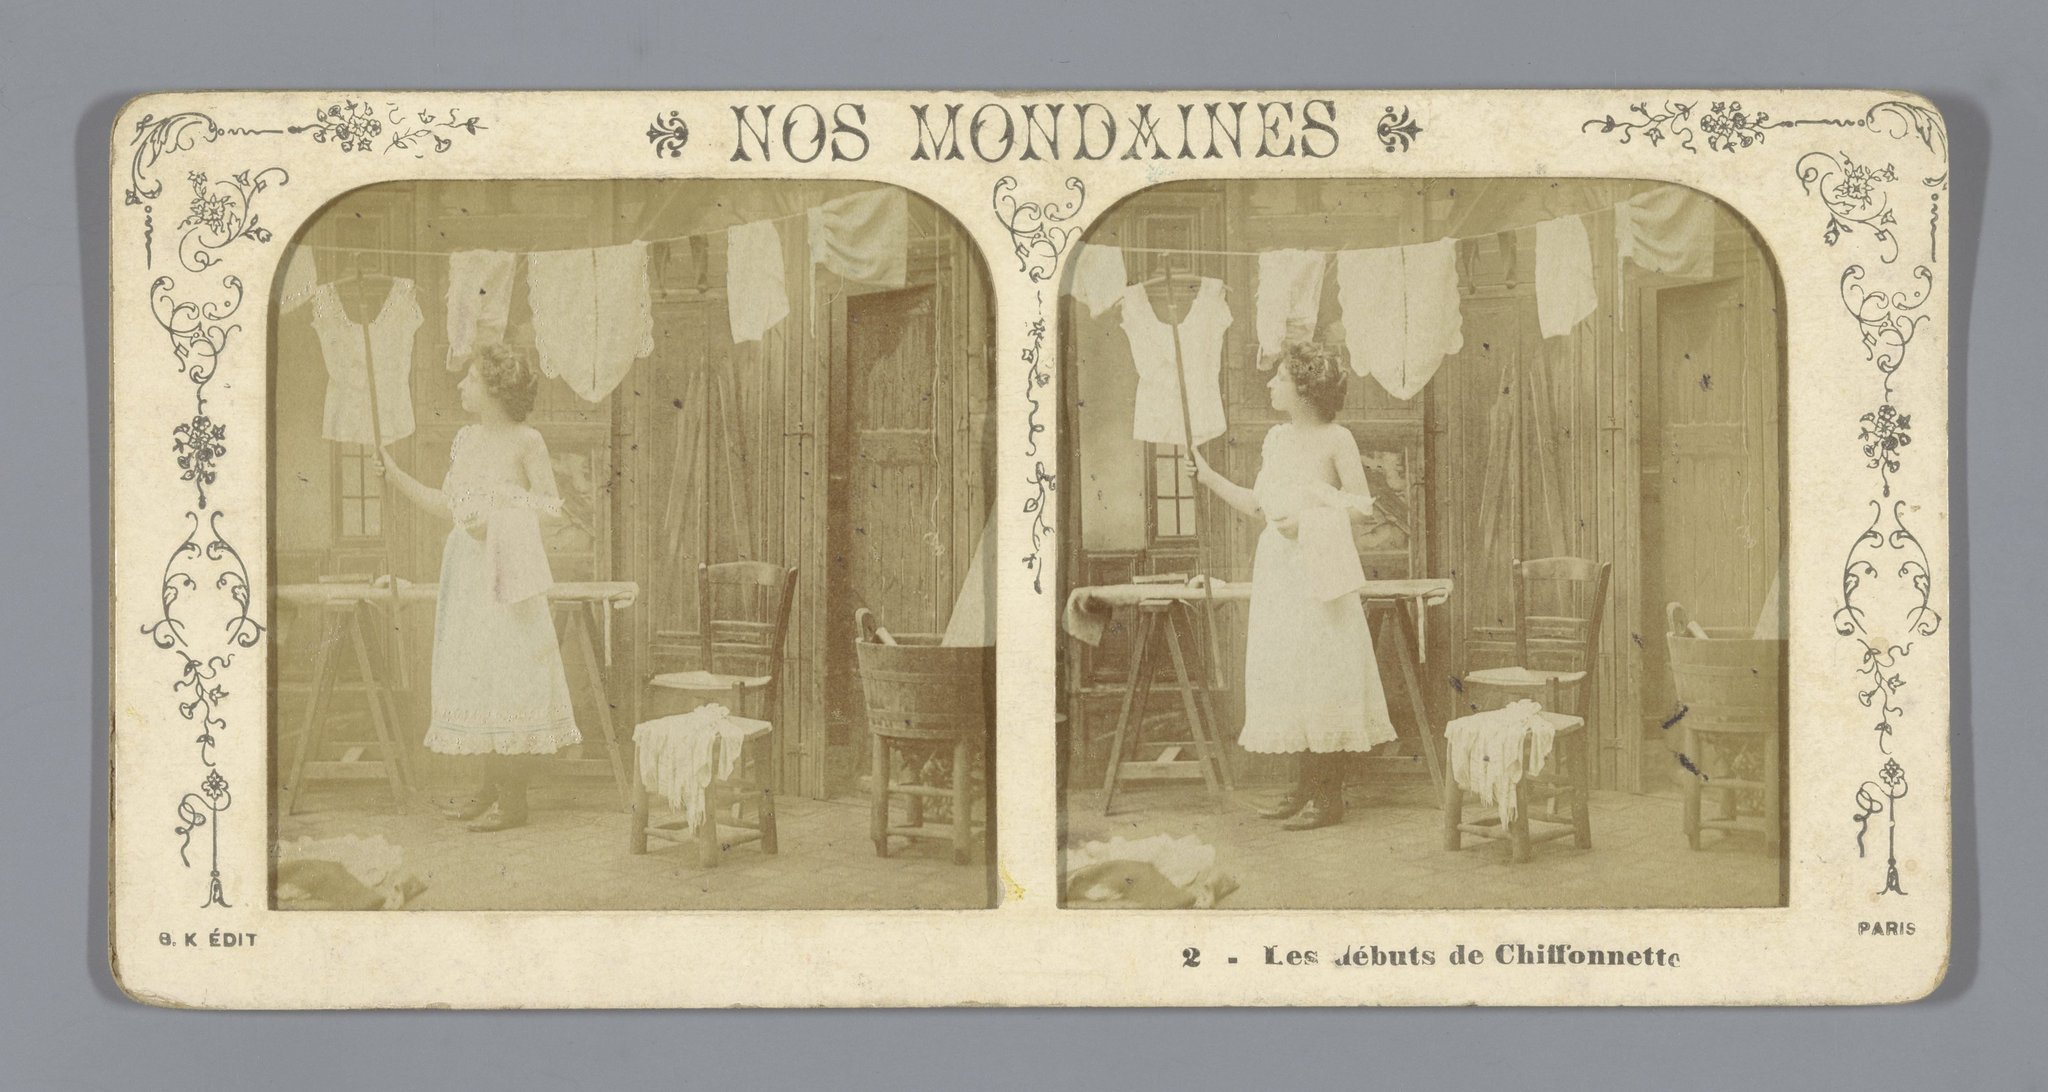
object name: tissue stereograph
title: Les débuts de chiffonnette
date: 1863-1875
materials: cardboard, paper, photographic support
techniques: albumen print, cutting, hand coloring, perforating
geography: france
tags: wash house, home laundry, laundry room, france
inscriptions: number: ‘2’